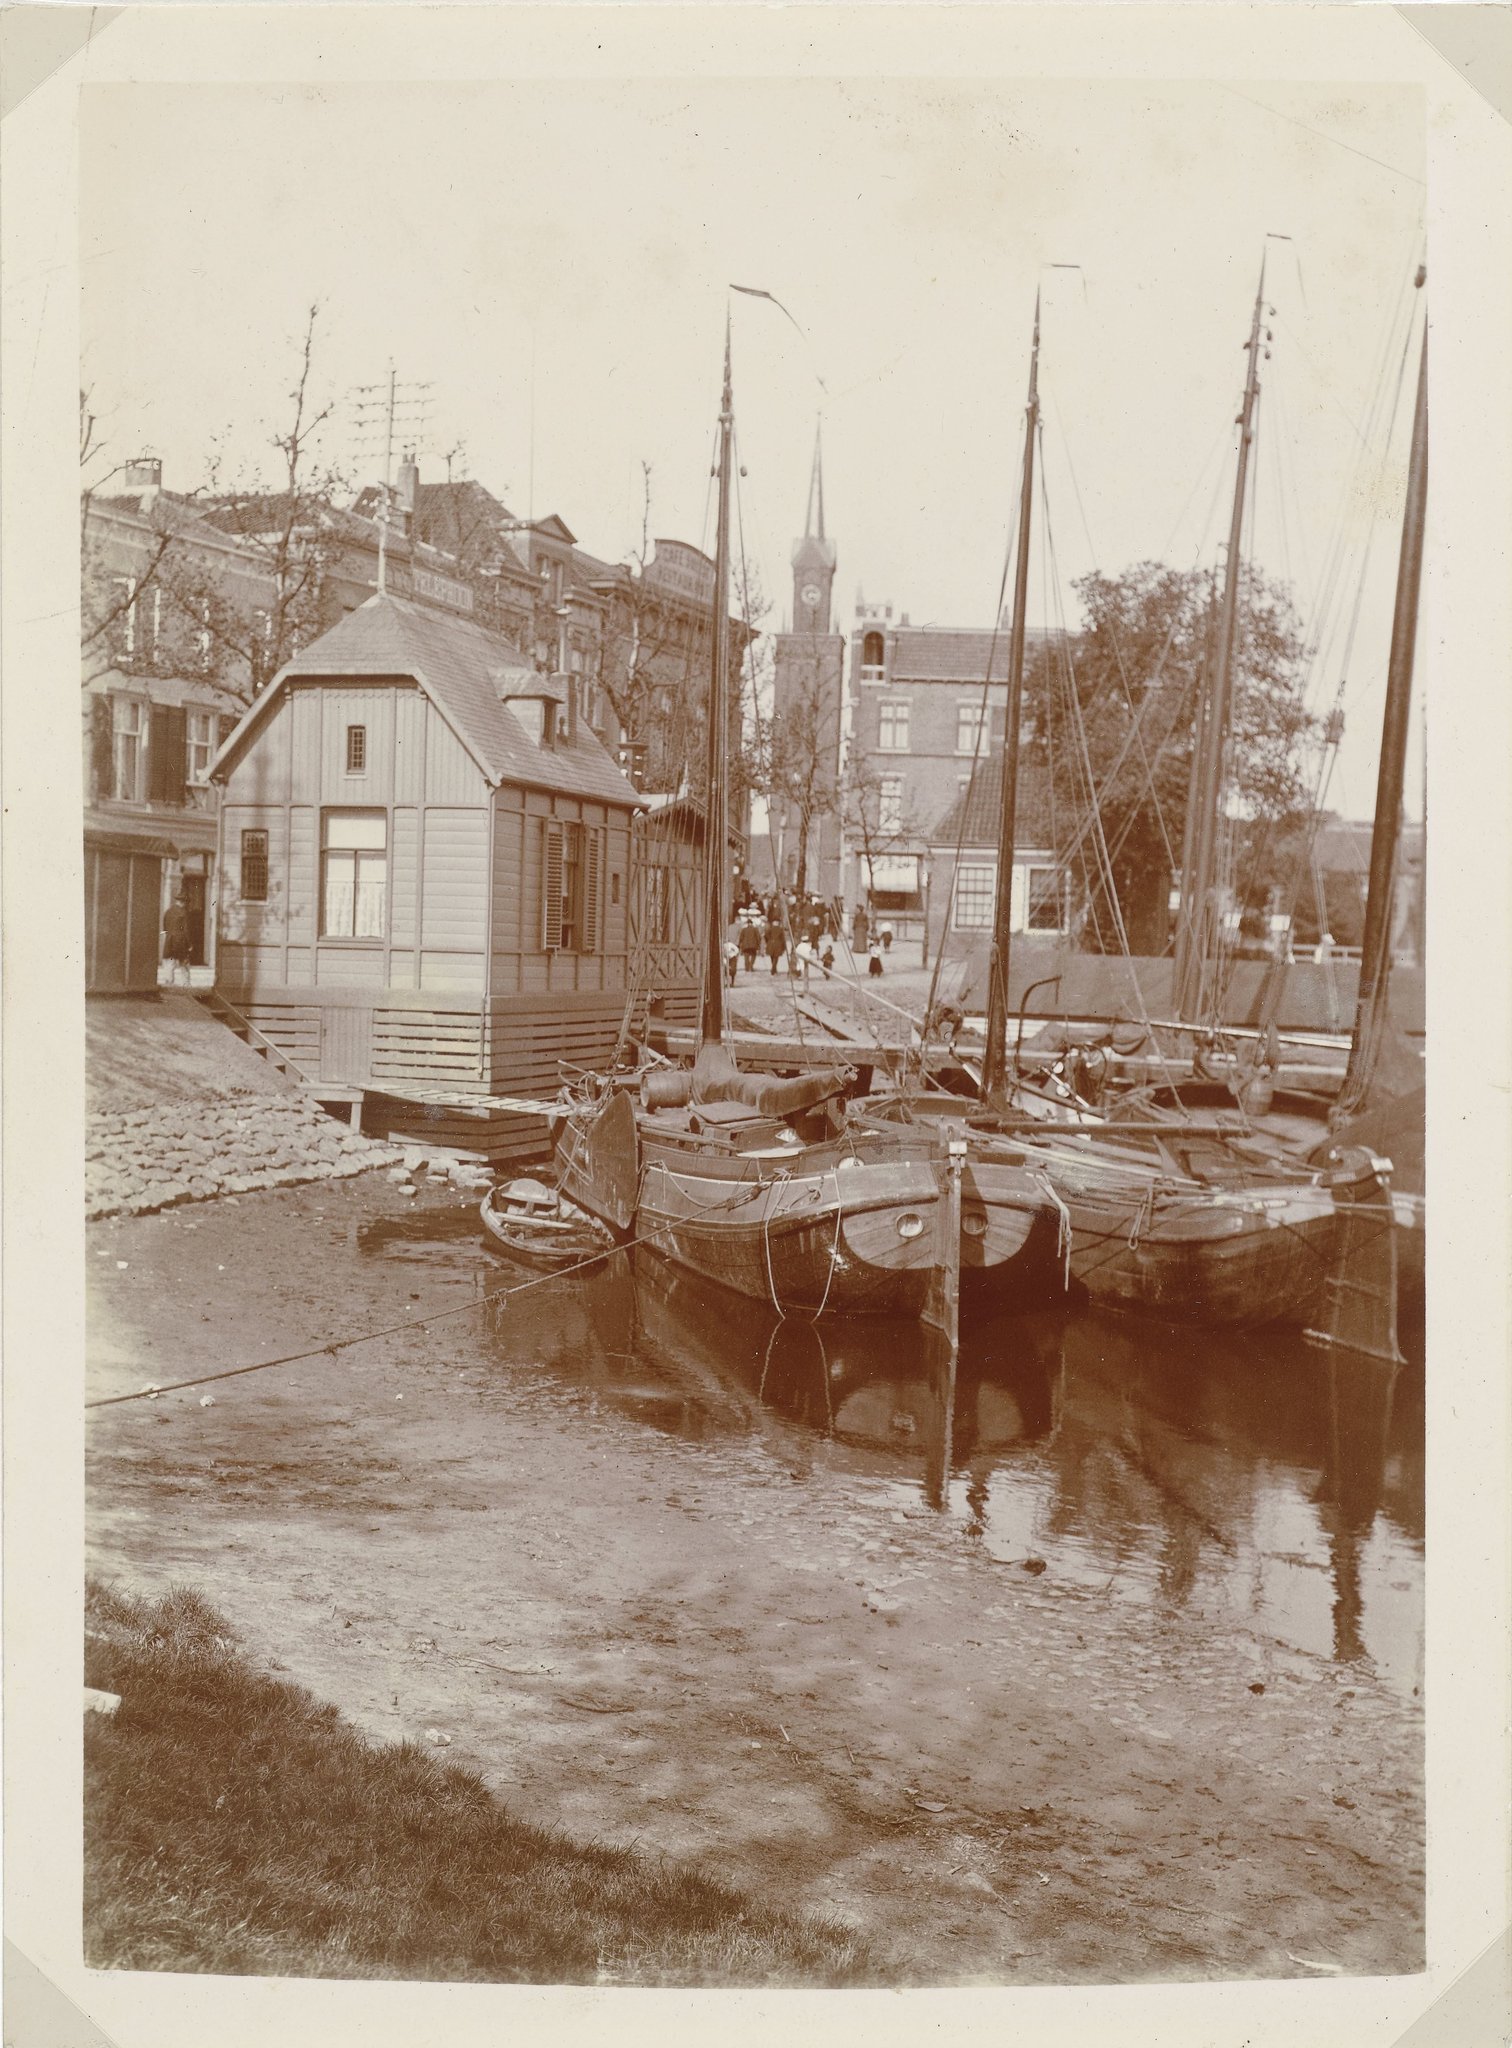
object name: photograph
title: Schepen aan de wal in Zaandam, Nederland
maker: james higson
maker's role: politician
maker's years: 1862-1933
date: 1904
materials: paper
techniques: gelatin silver print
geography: zaandam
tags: ships (in general)